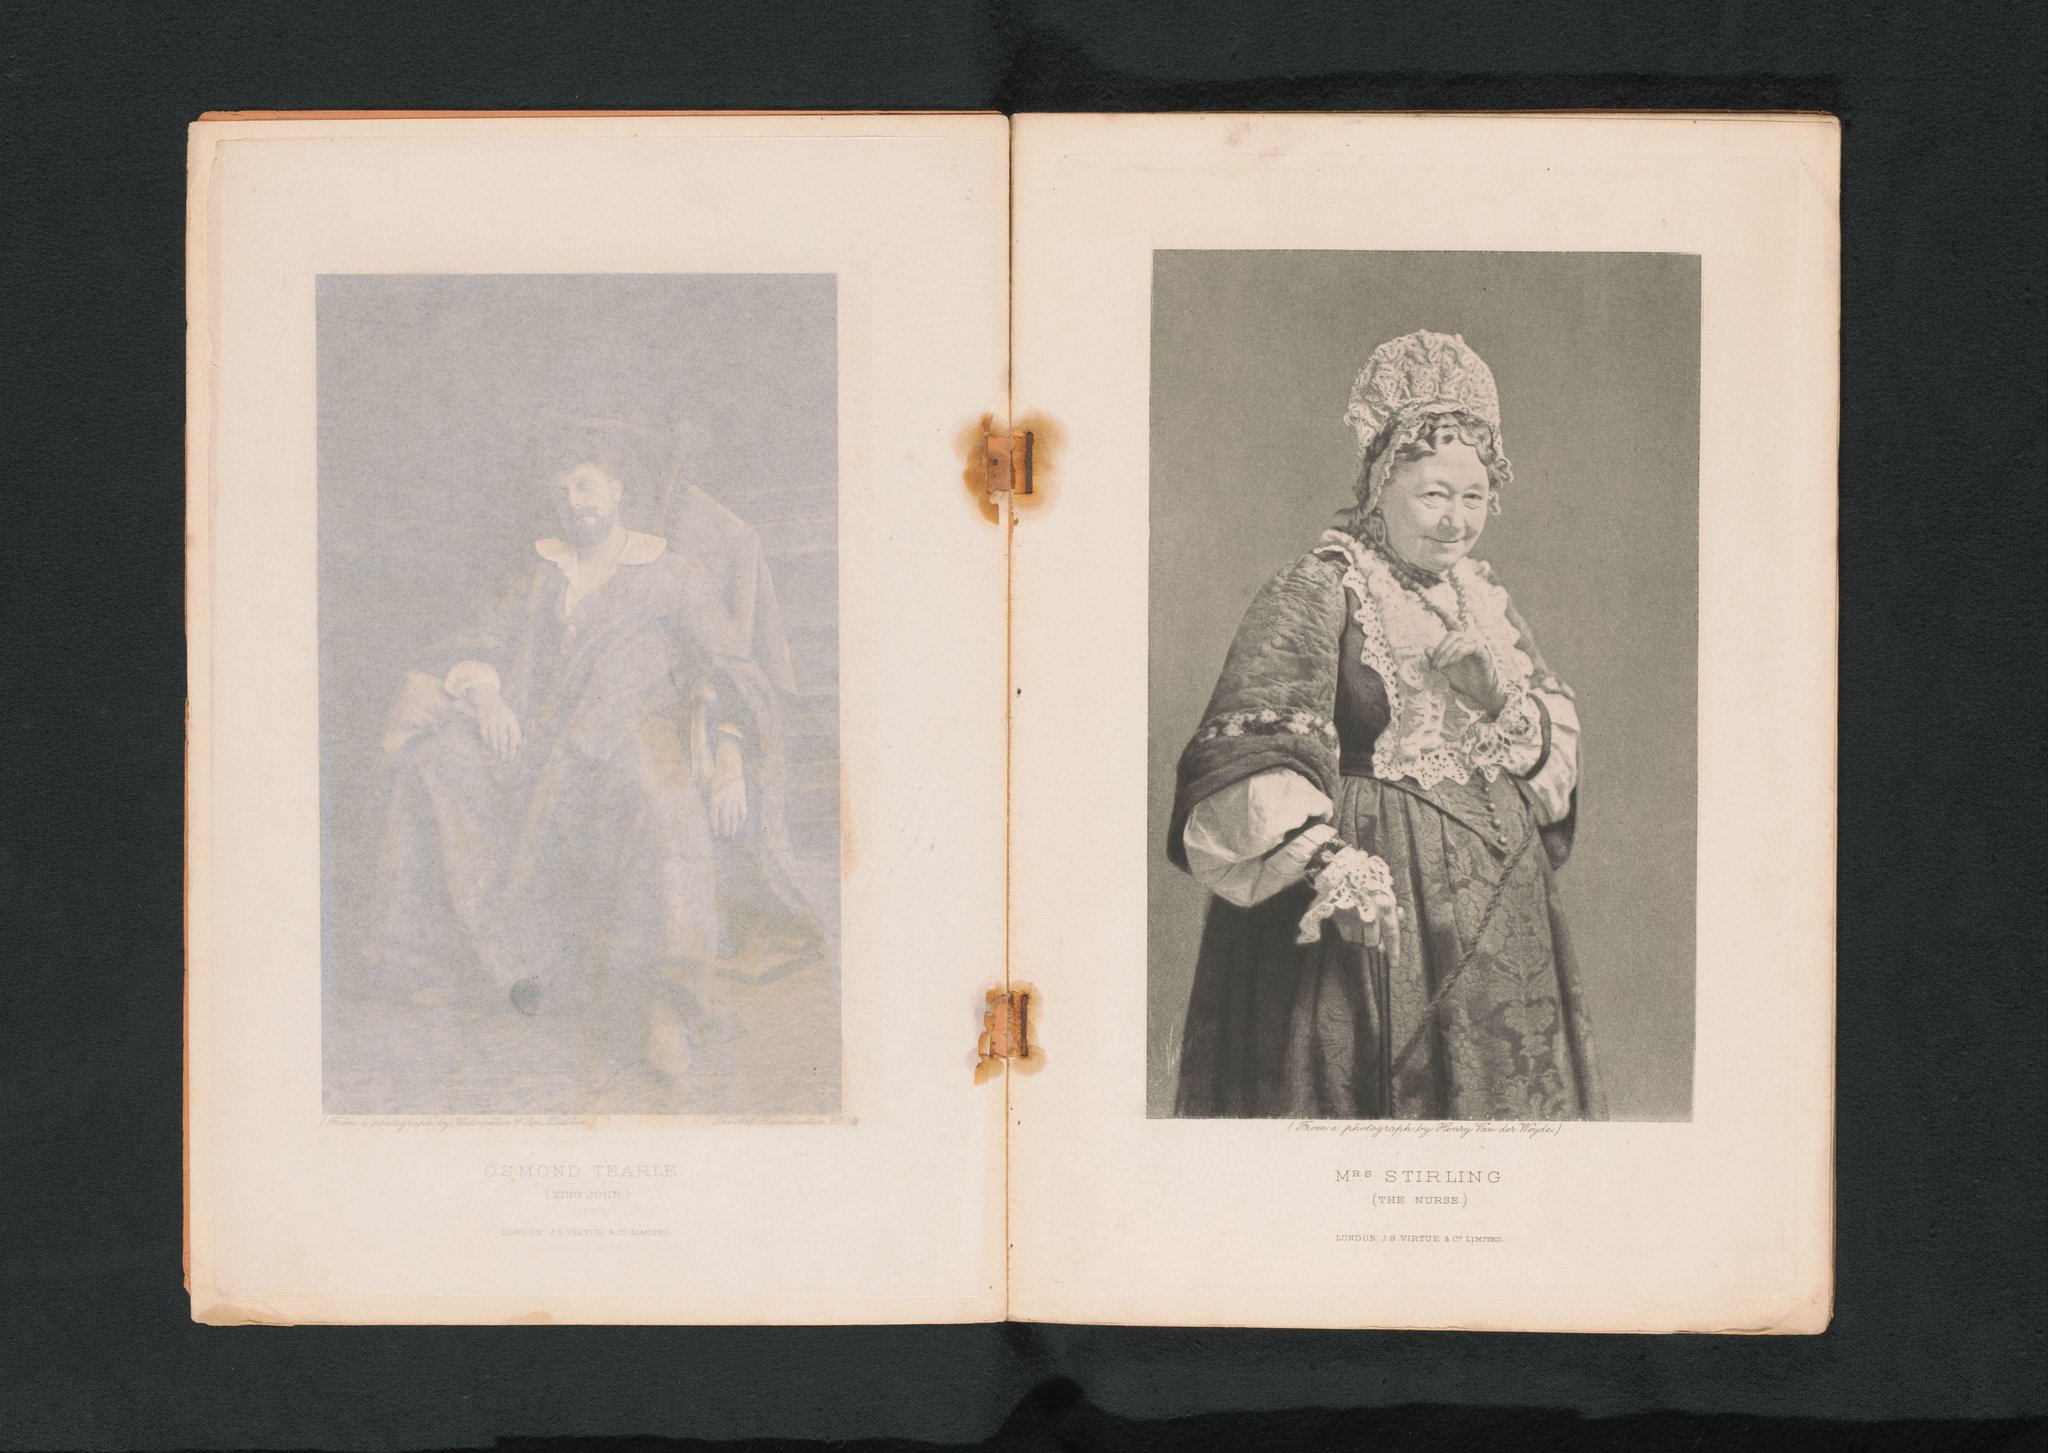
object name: page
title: Mrs Stirling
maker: henry van der weyde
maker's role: fotograaf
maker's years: 1838-1924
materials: paper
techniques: photoaquatint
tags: historical persons - bb - woman, portrait of actor, actress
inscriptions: inscription: ‘(THE NURSE.)’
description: Prent op derde ongenummerde pagina na voorblad.